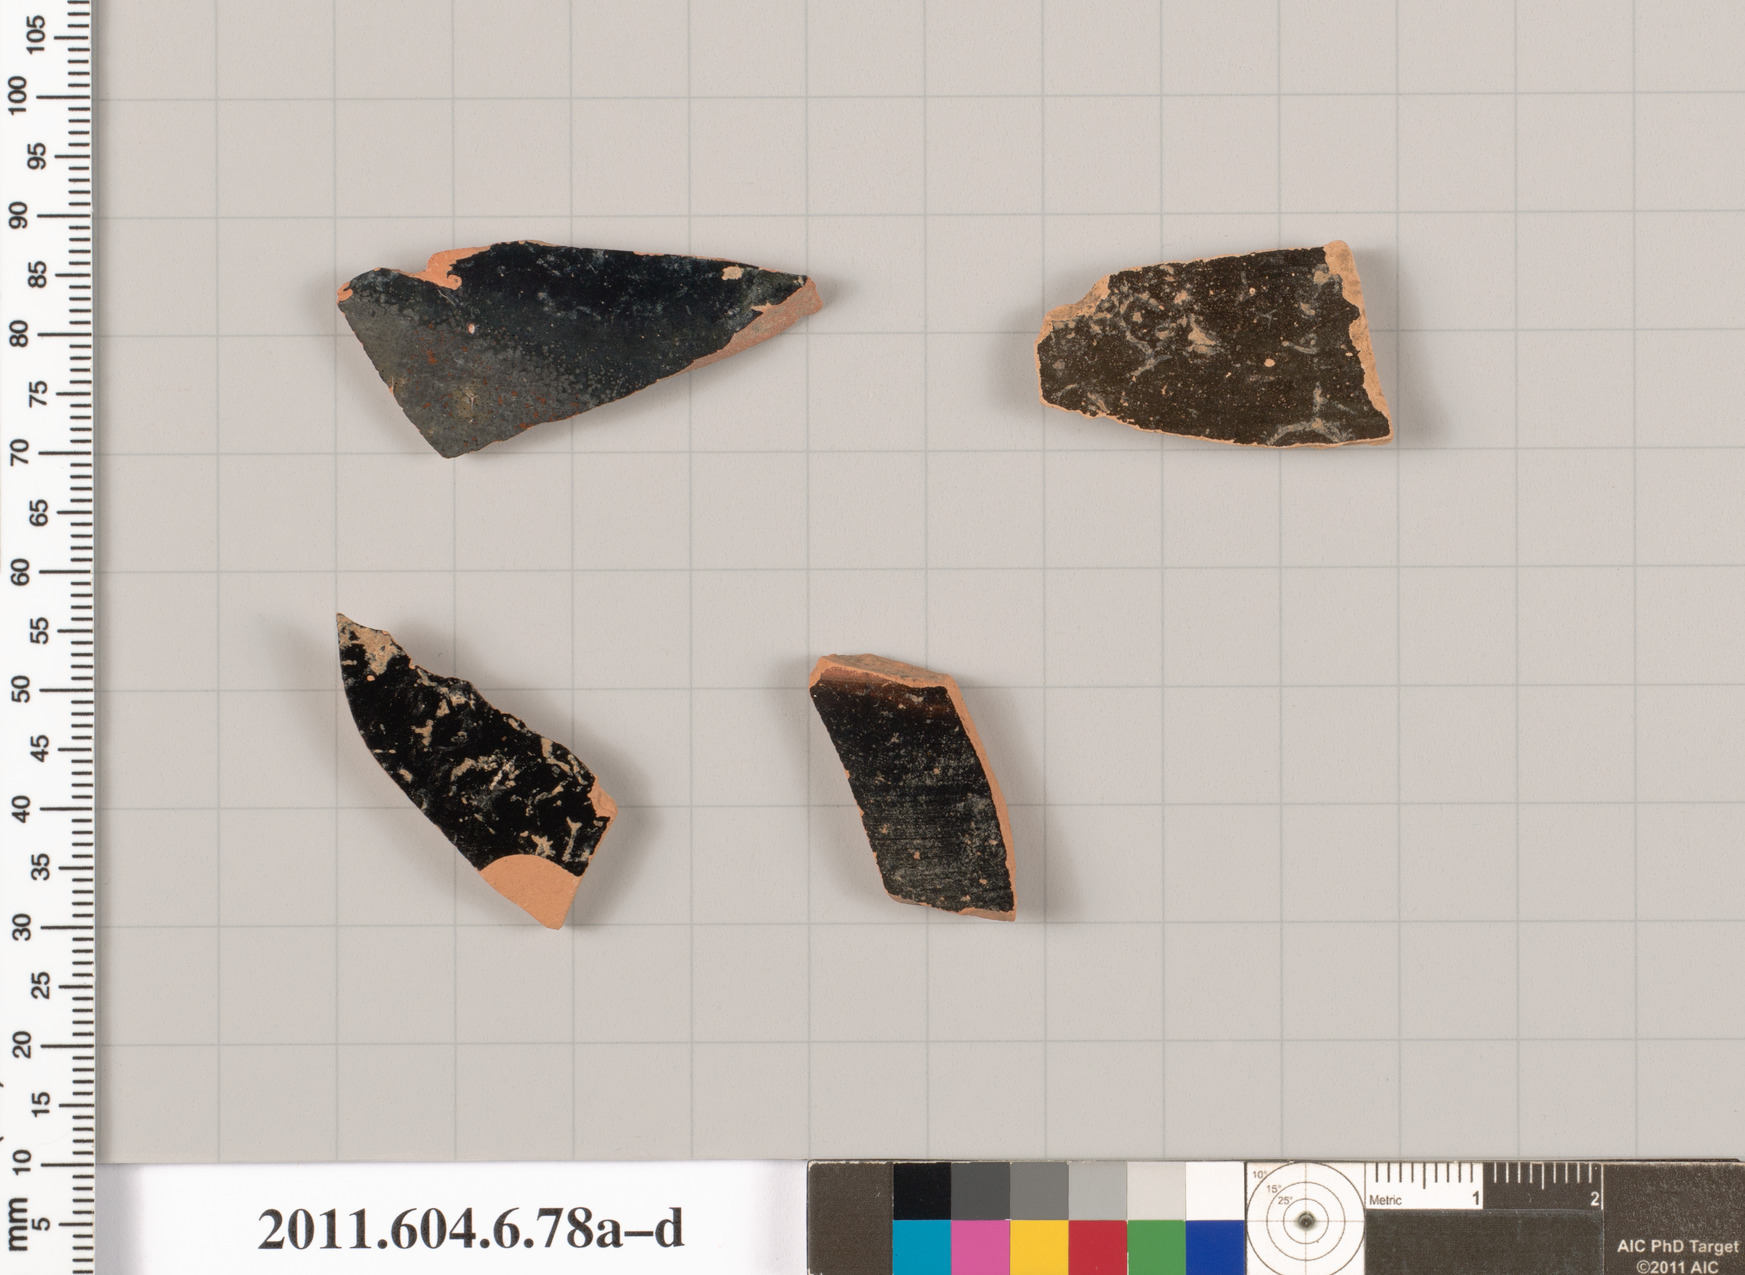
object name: undetermined open shape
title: Terracotta fragments of open shapes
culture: greek, attic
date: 600-401 BCE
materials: terracotta